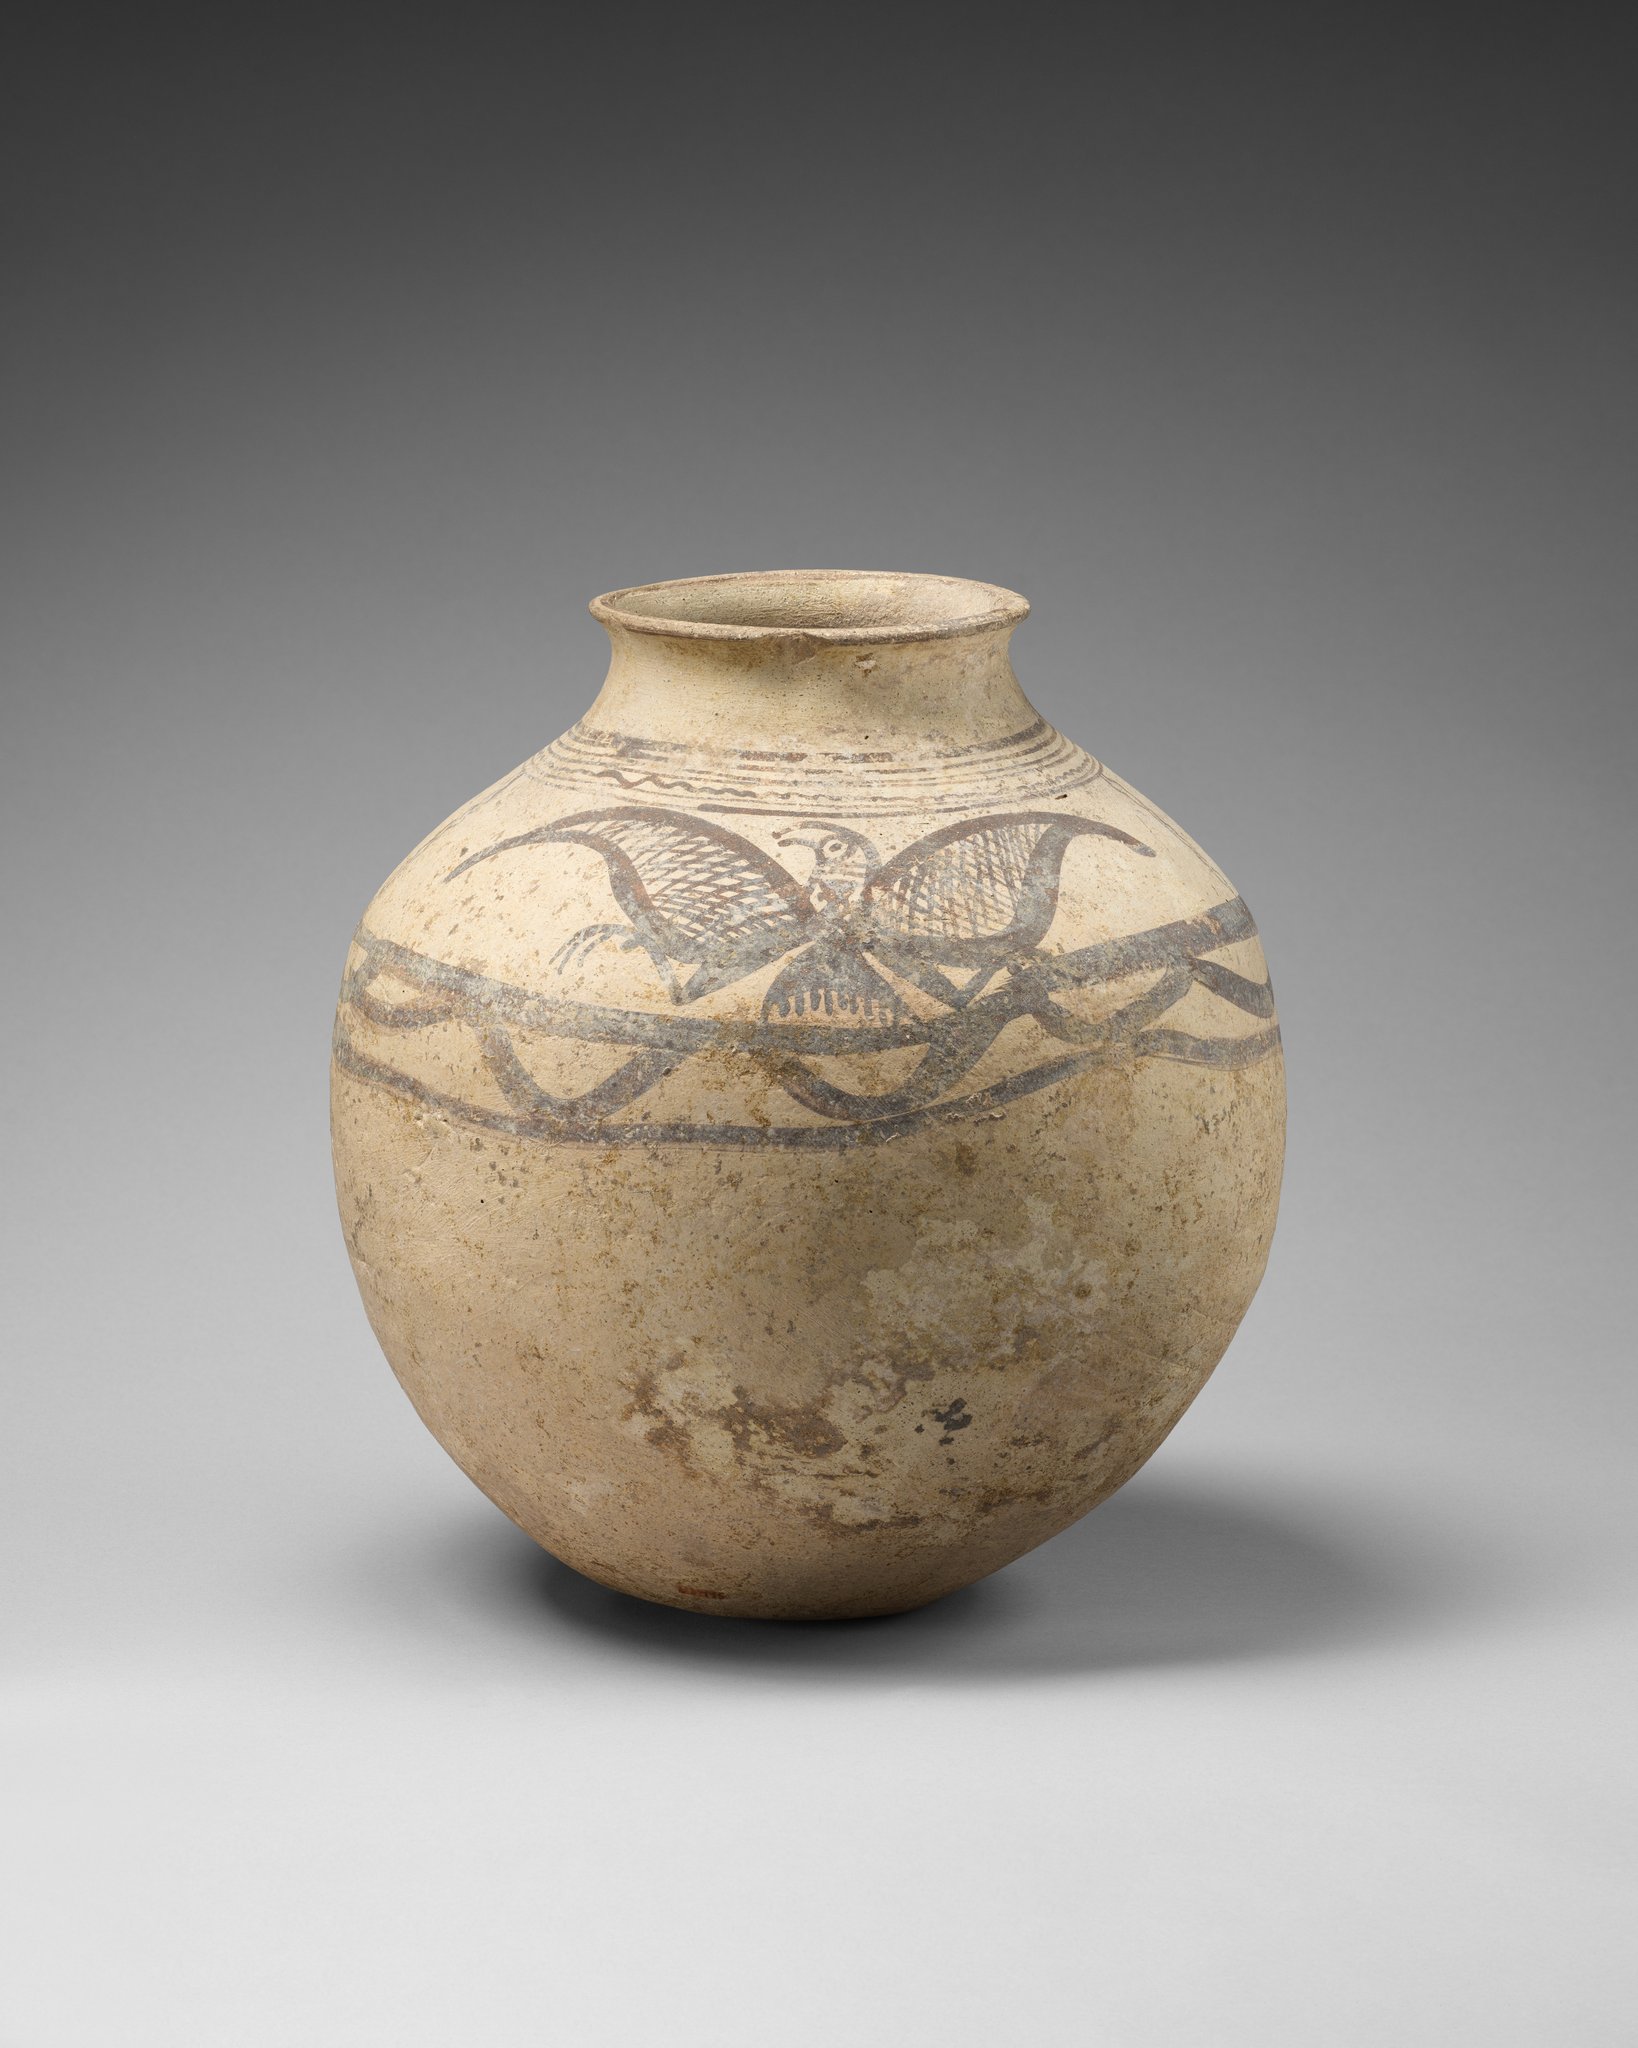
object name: jar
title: Jar with painted eagle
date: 2500-1900 BCE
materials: ceramic, paint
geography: western iran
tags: eagles